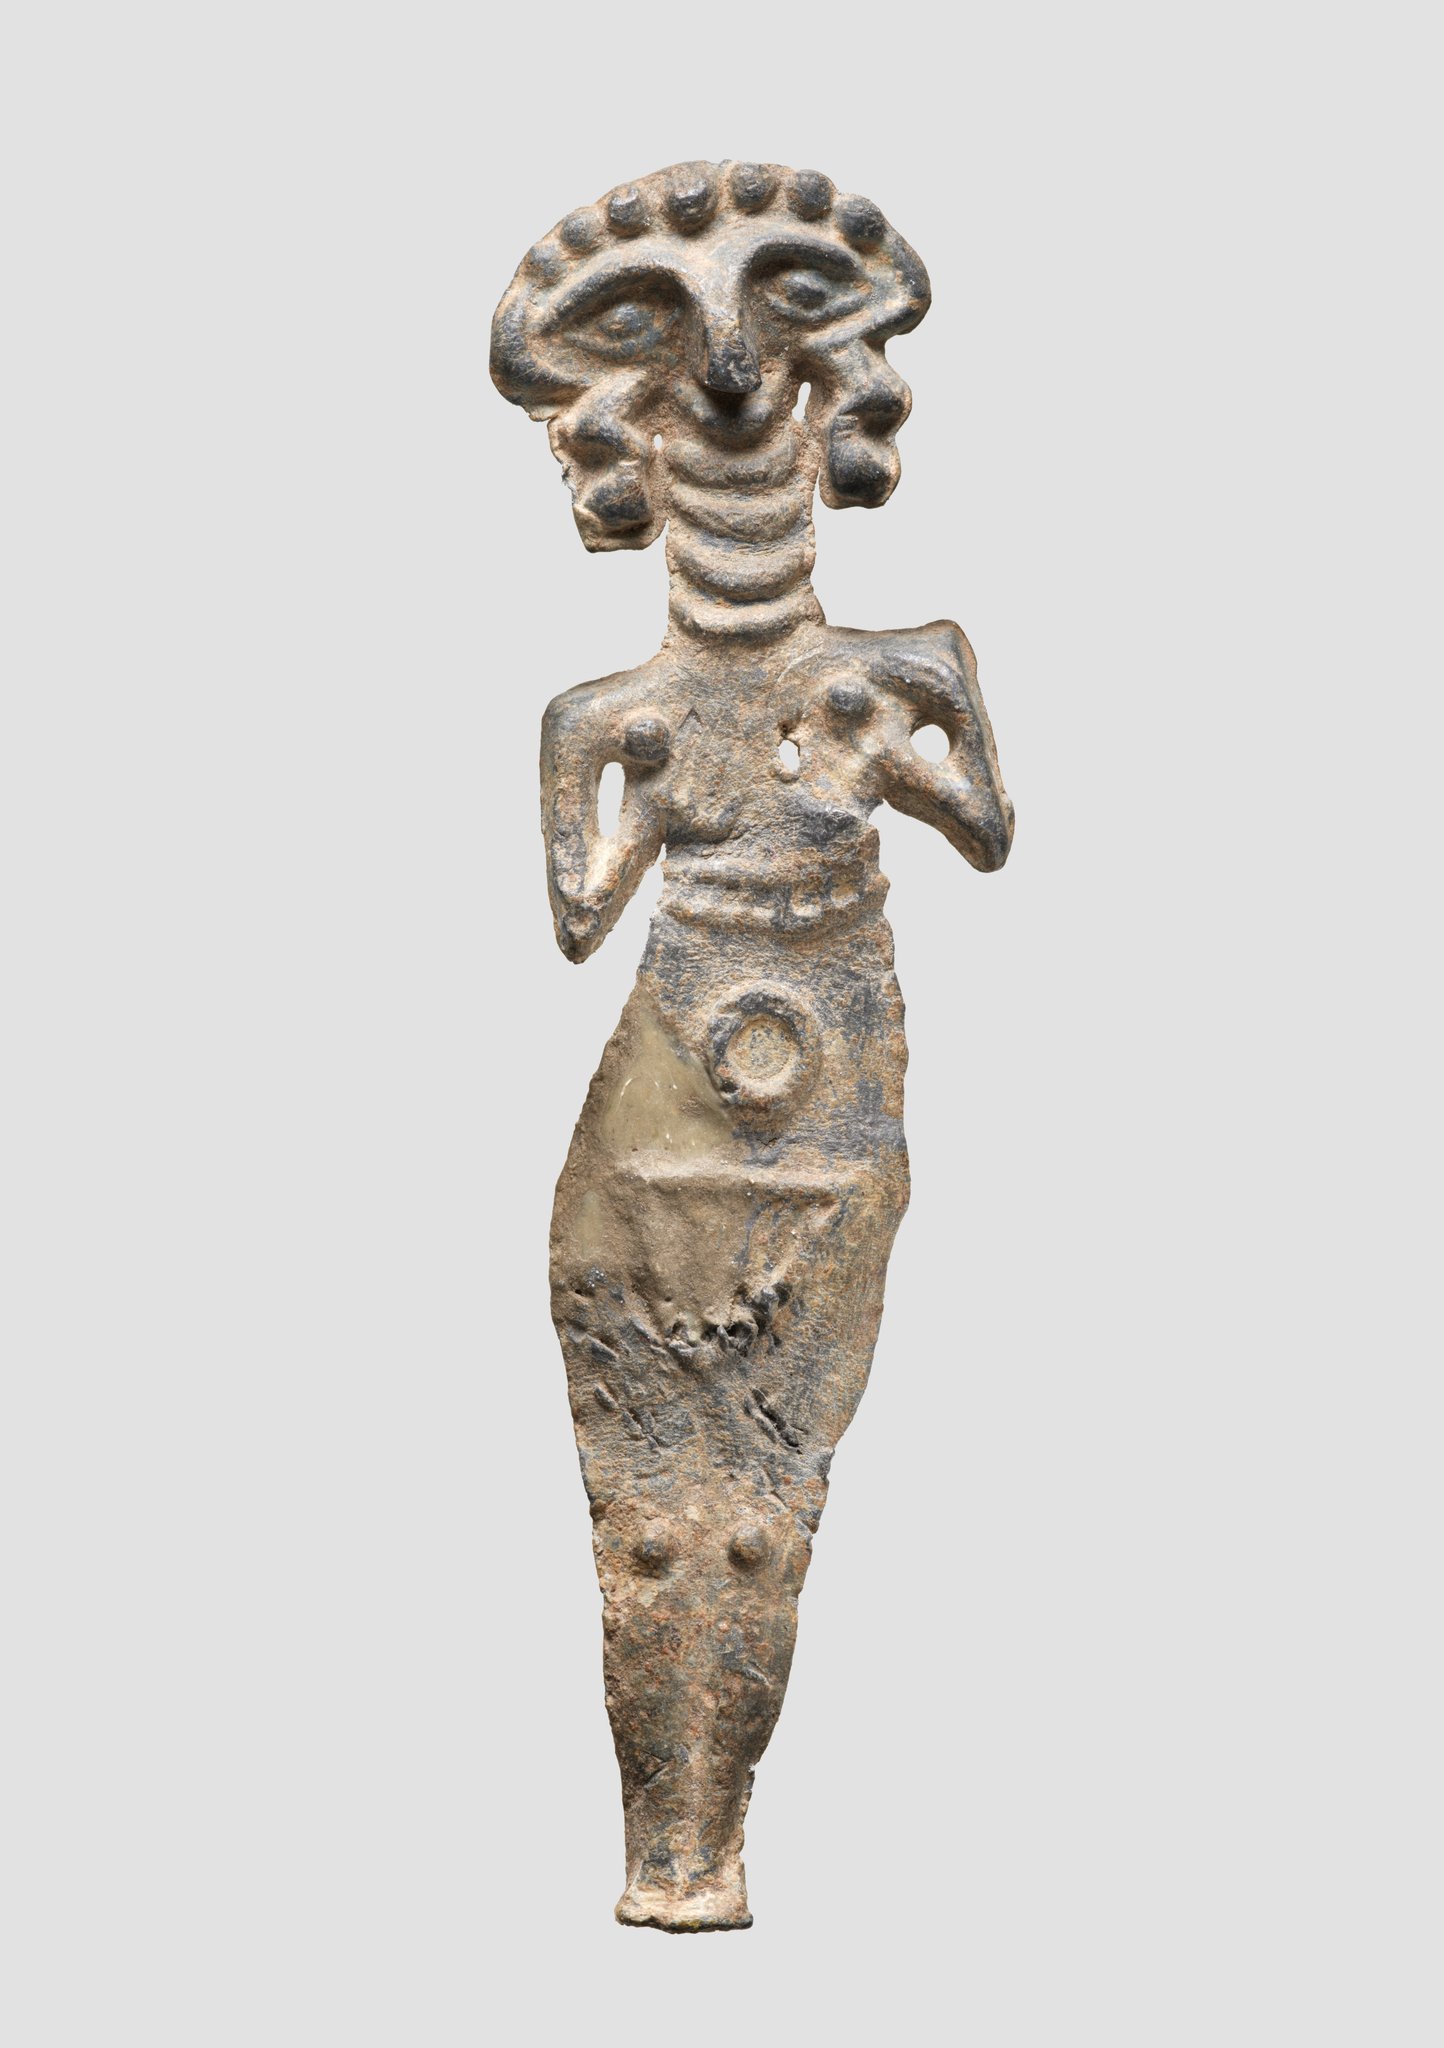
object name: sculpture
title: Nude female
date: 2333-2001 BCE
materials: lead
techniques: casting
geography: anatolia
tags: female nudes